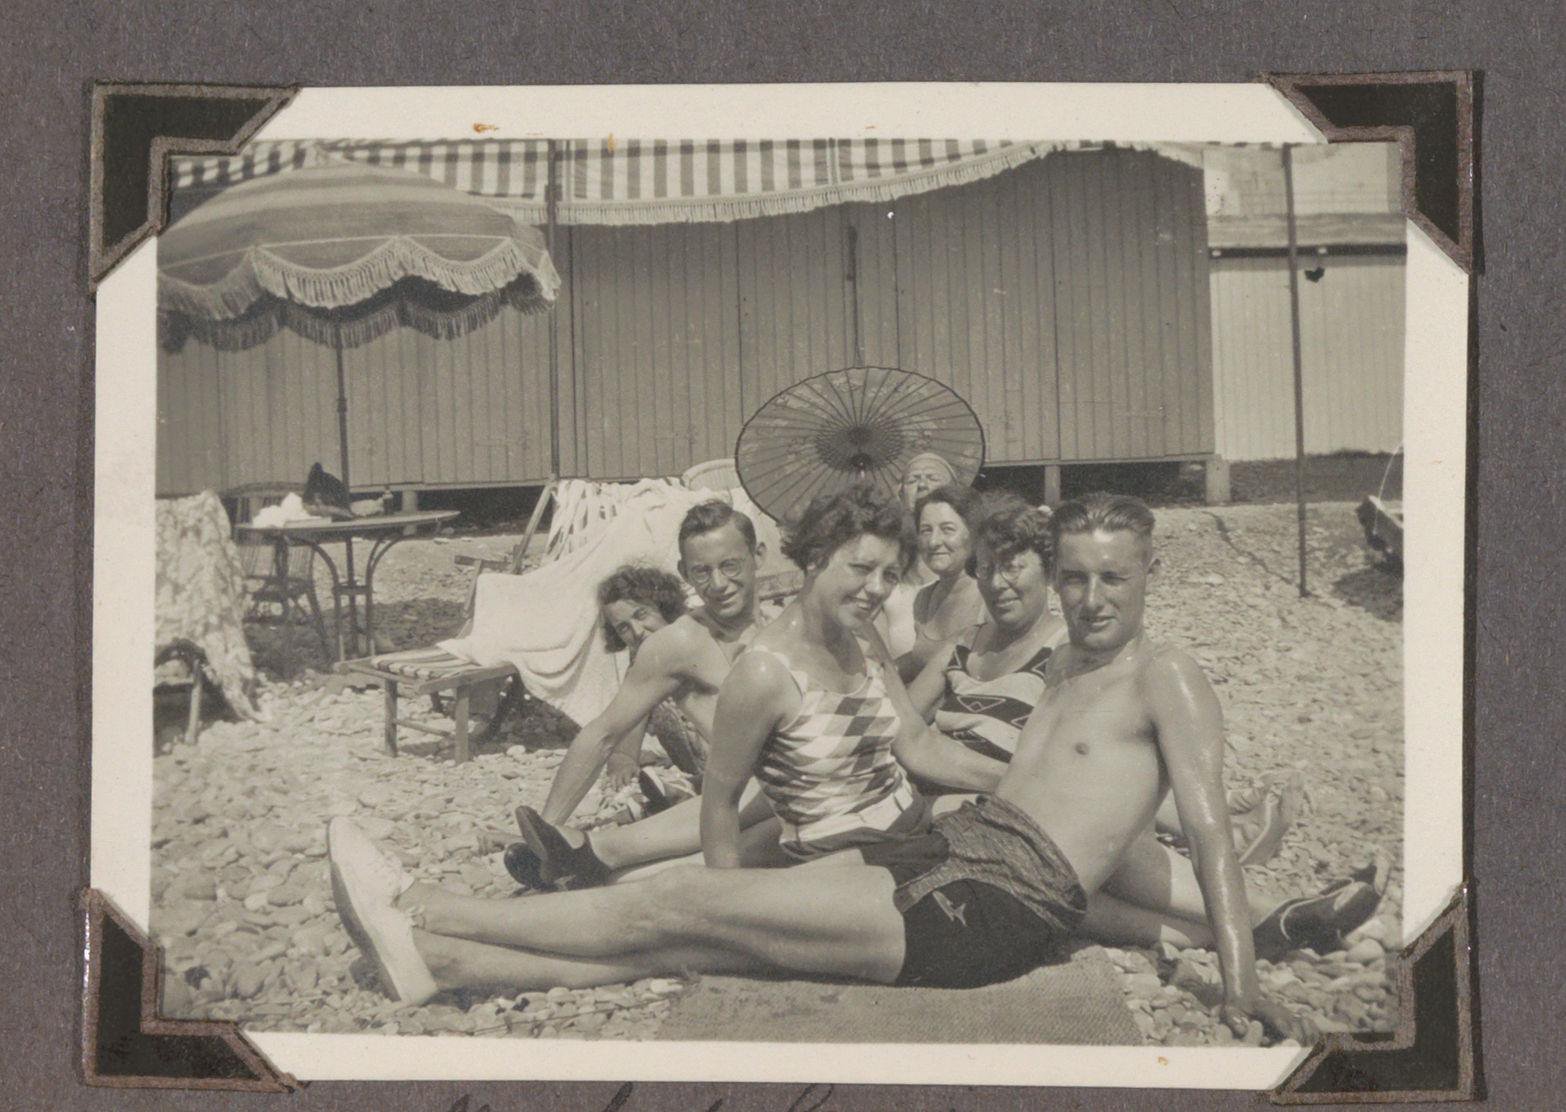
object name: photograph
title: Gezelschap in zwemkleding bij Roquebrune-Cap-Martin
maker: Anonymous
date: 1930-1935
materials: photographic support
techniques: gelatin silver print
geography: roquebrune-cap-martin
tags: swimming (sport) (+ equipment, outfit (sports, games, etc.))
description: Onderdeel van Fotoalbum met opnames van vakanties in Zuid-Frankrijk.